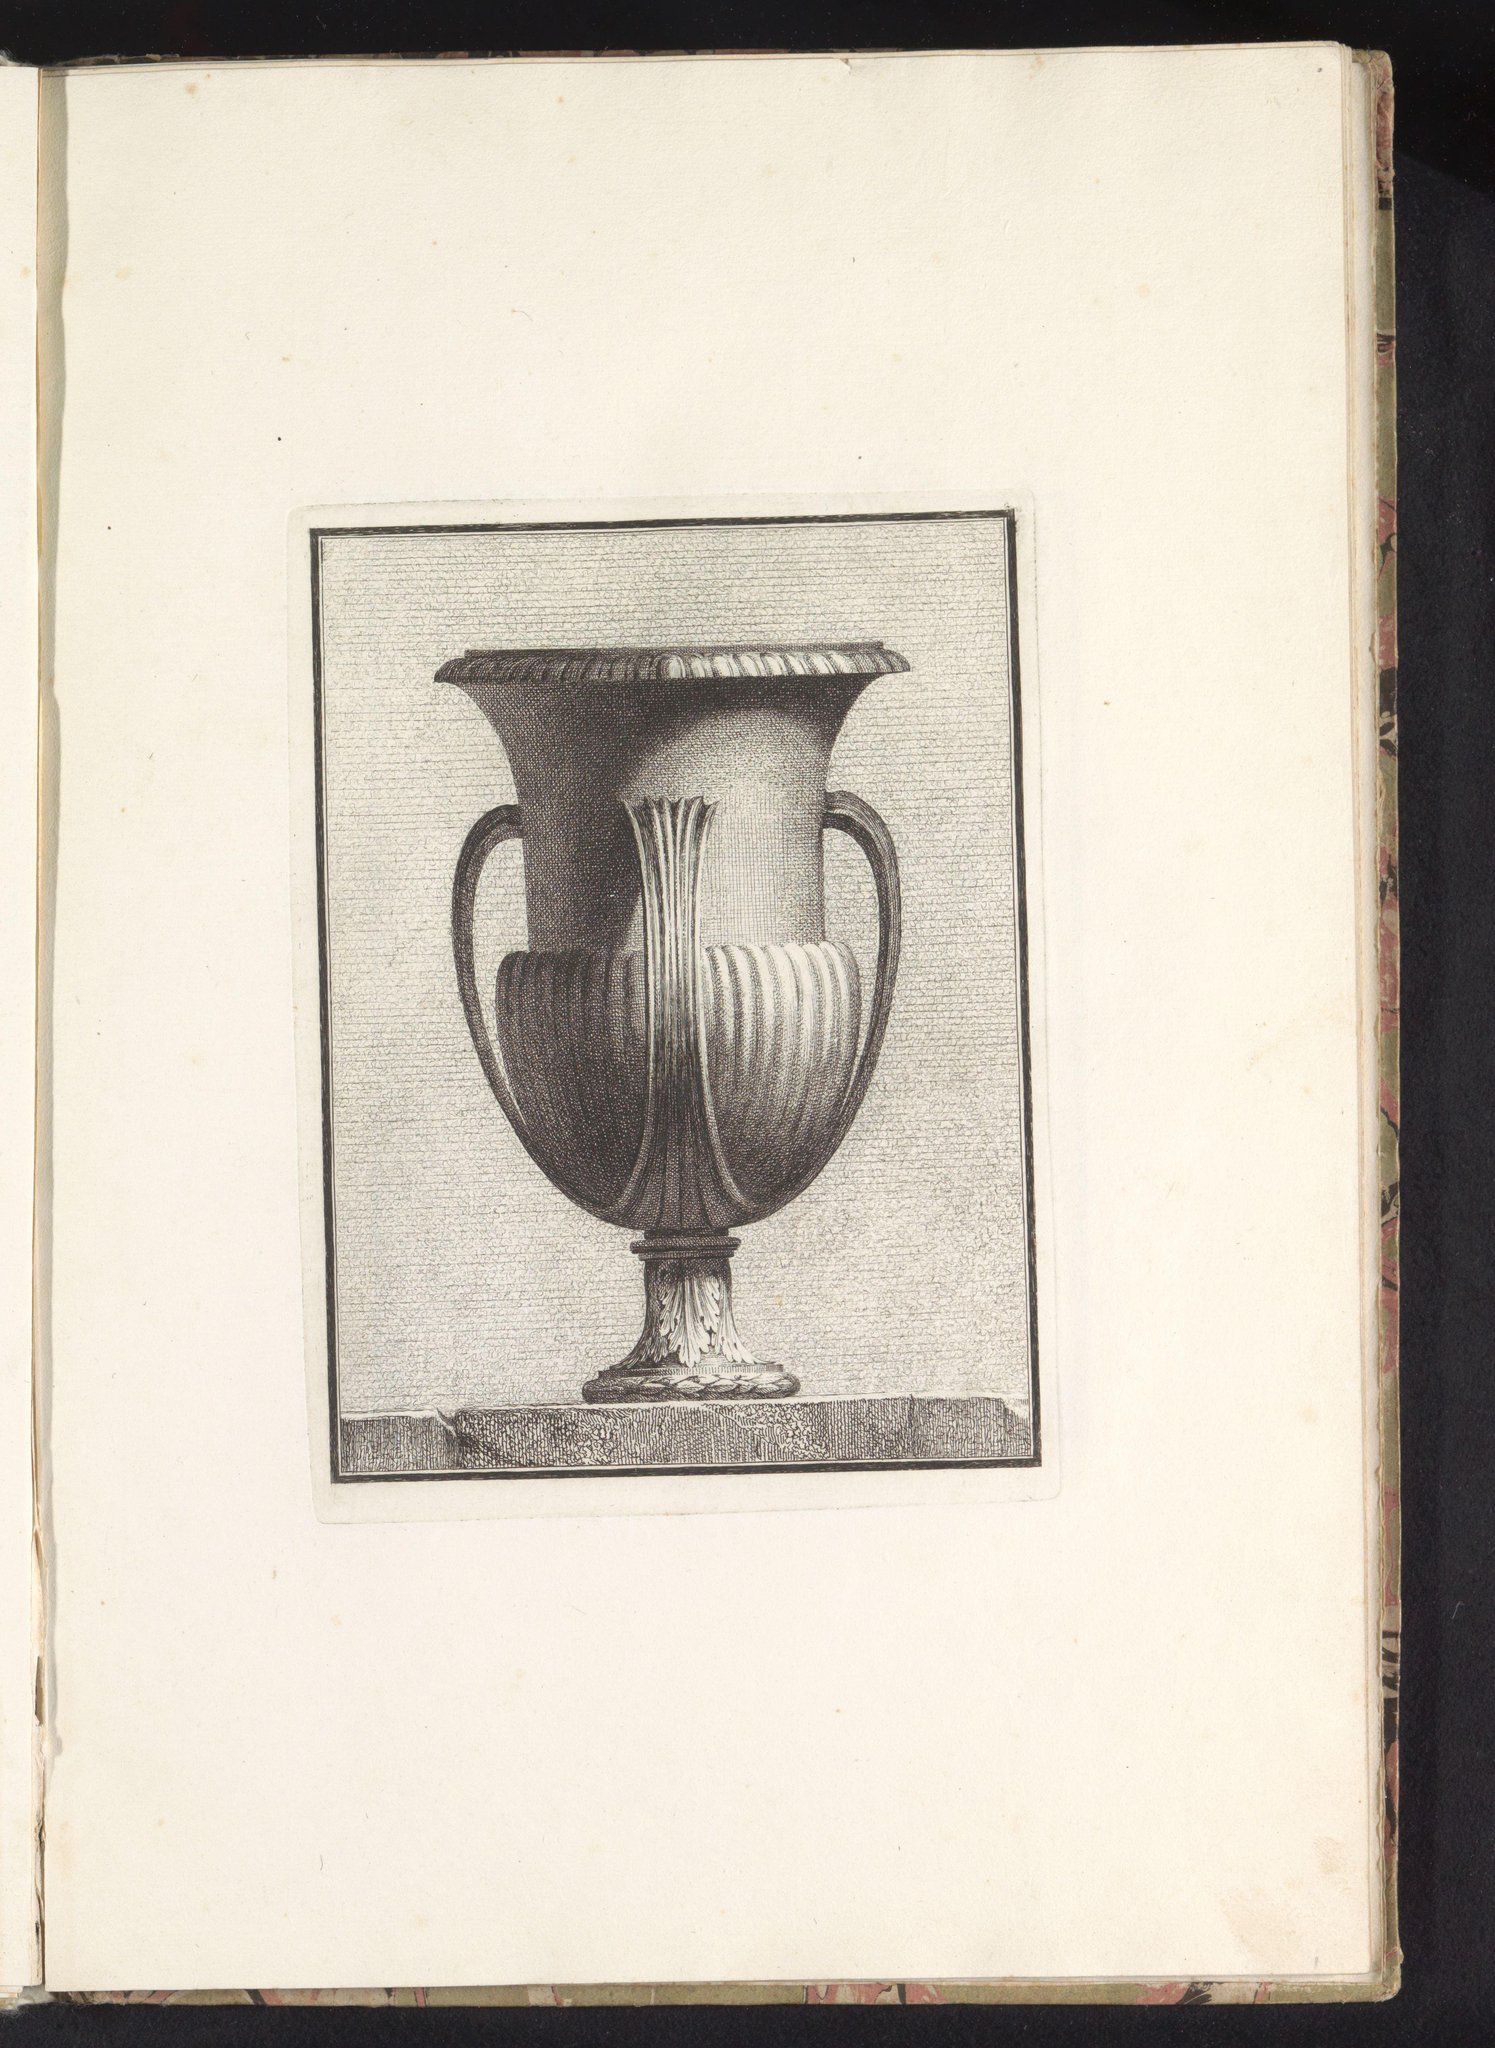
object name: album leaf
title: Ornamentele vazen uit de collectie van Guillaume du Tillot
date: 1764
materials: paper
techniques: etching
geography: parma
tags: vase ~ ornament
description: Amfoor met vier oren (drie zichtbaar) die van de voet naar de hals lopen. De voet is gedecoreerd met acanthusbladeren. De vaas staat op een muur. No. 2 uit serie van 31. Prent maakt deel uit van een album. Gedrukt recto rechtsboven: 2.